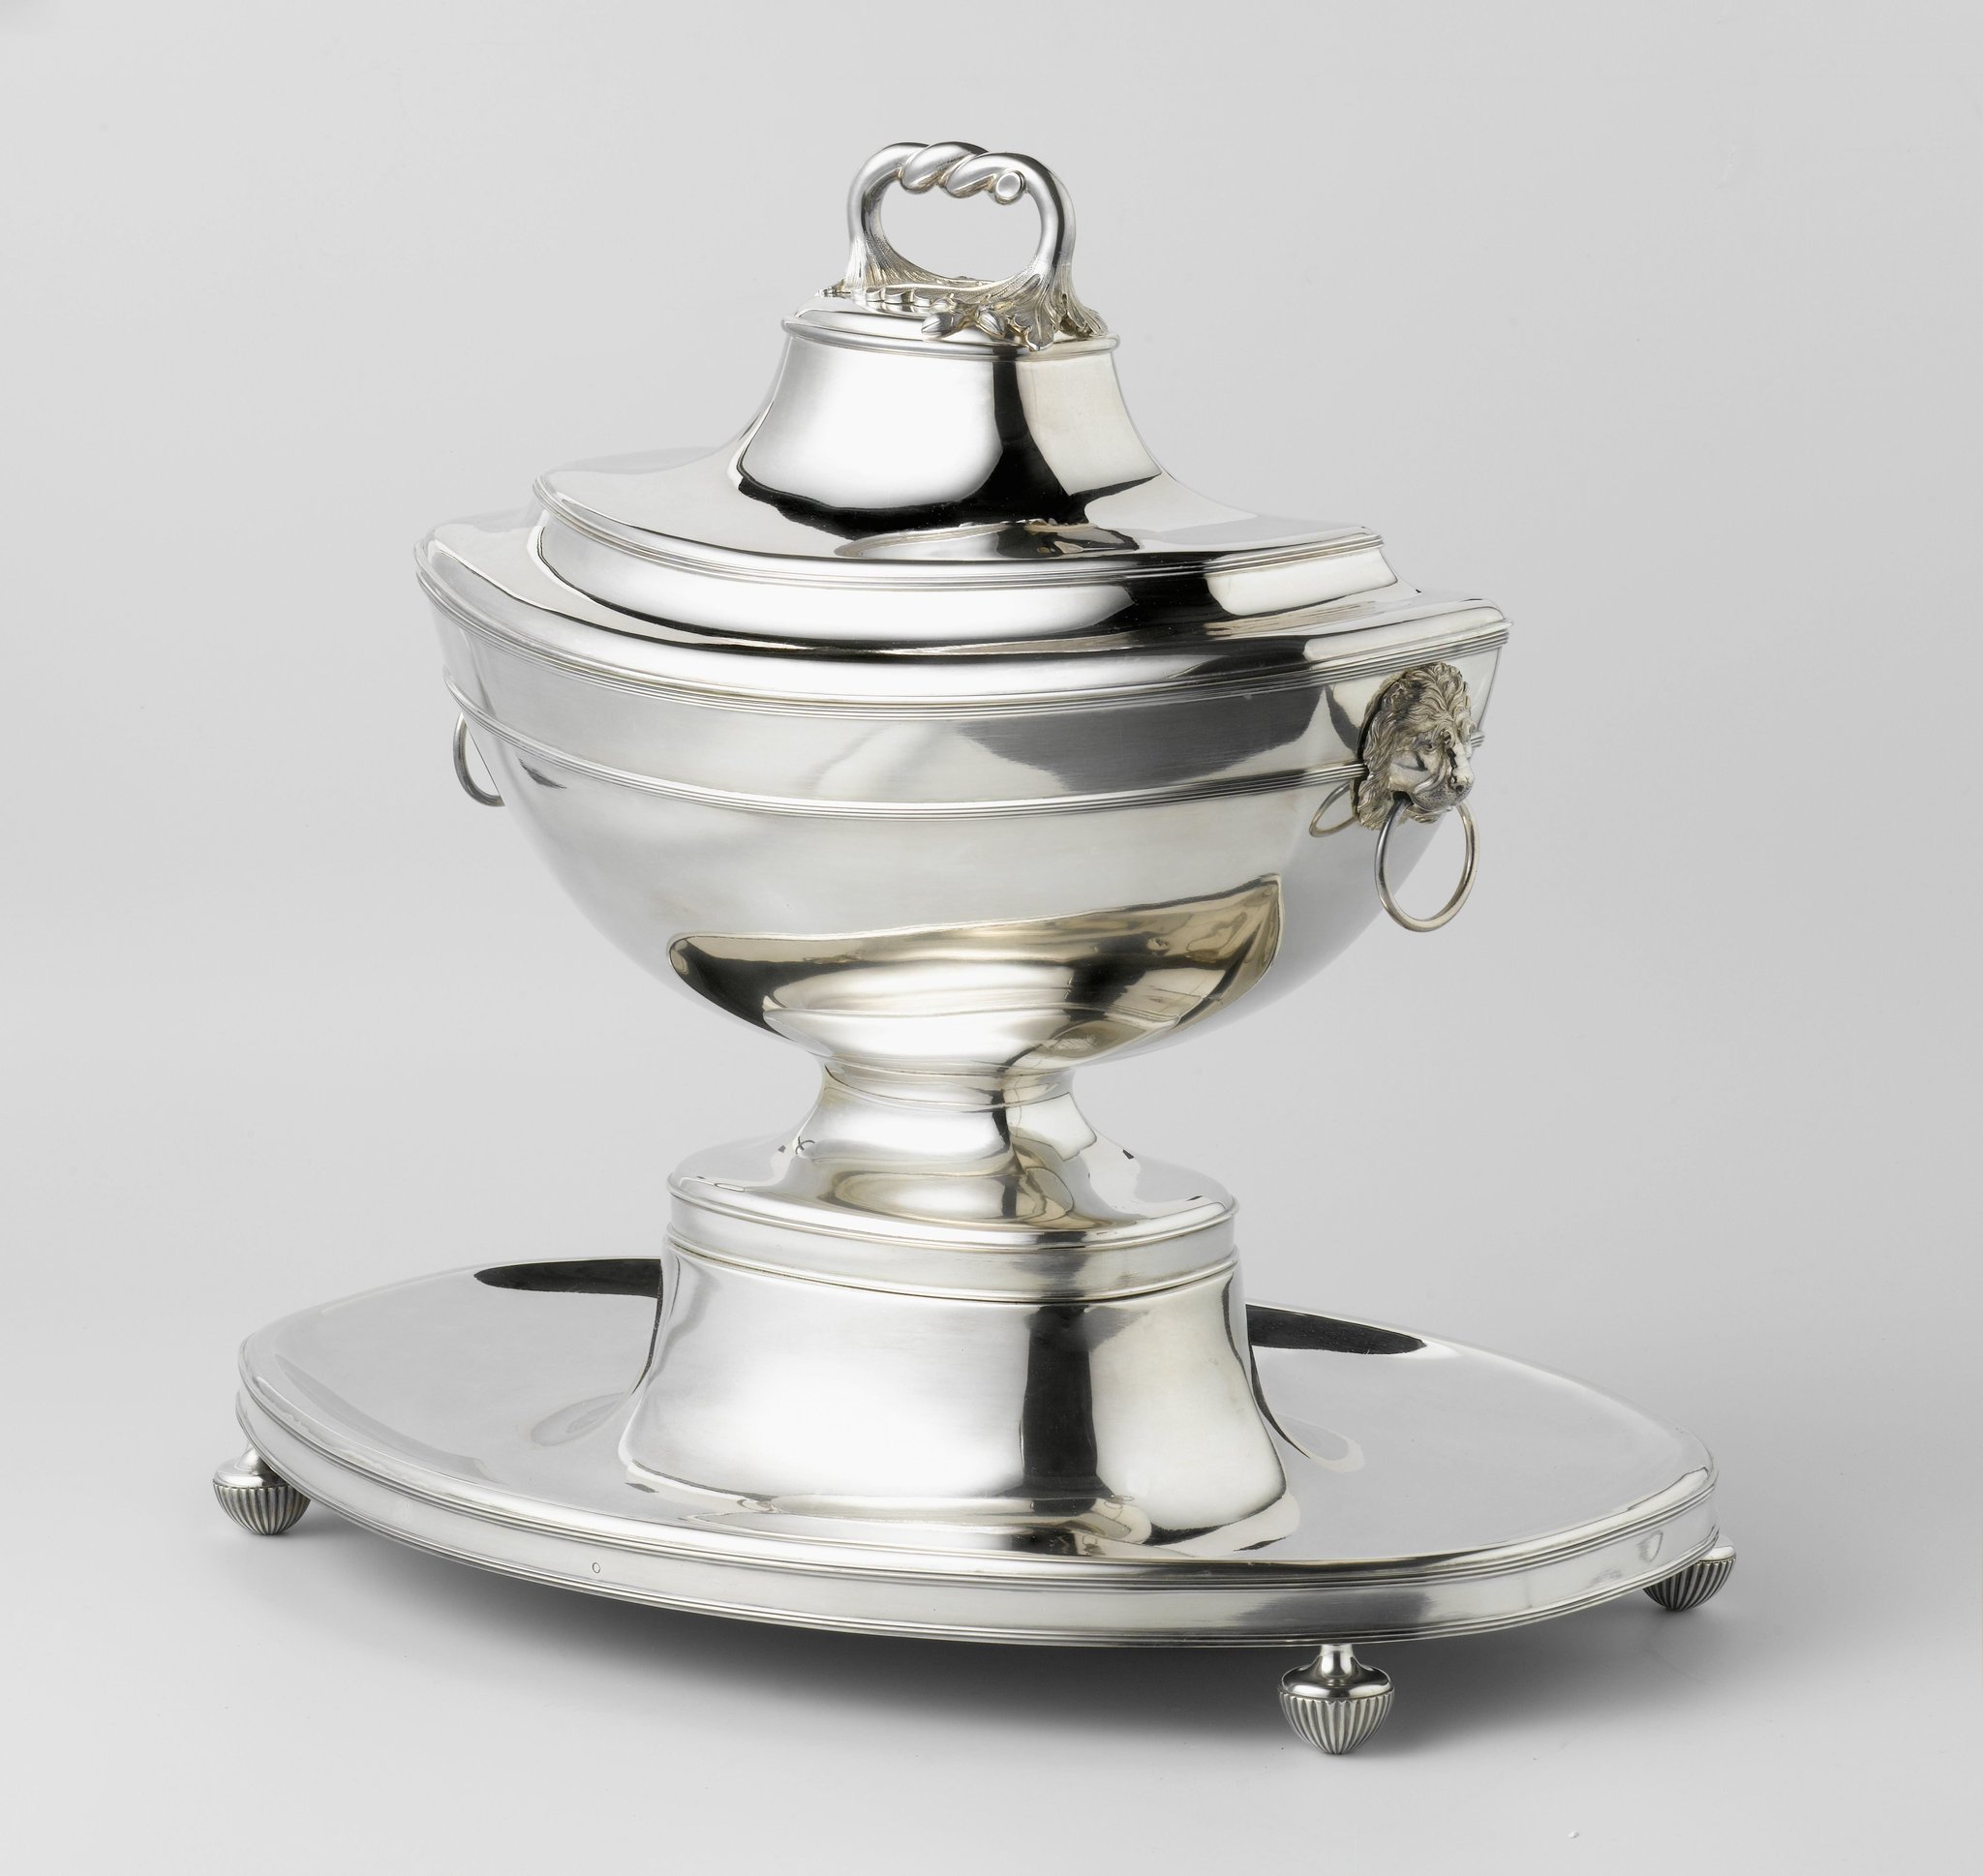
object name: soup tureen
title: Parts of the Silver Dinner Service for the Prince of Orange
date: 1816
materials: silver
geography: amsterdam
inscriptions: alloy mark, date letter: ‘G’, duty mark: ‘I’, maker's mark: ‘JS’, retailer's mark: ‘BENNEWITZ & BONEBAKKER’, assayer's mark: ‘S1’, maker's mark: ‘DLB’, date letter: ‘H’, assay office mark: ‘A’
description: William Prince of Orange (later William II) and the Russian grand duchess Anna Pavlovna were married in St Petersburg in 1816. Back in the Netherlands, they were showered with wedding gifts. The City of Amsterdam commissioned a 419-piece silver dinner service, a small part of which is on view here. The House of Orange family coat of arms features the Dutch lion. Most appropriately, the handles of the soup tureen are in the shape of lion heads.